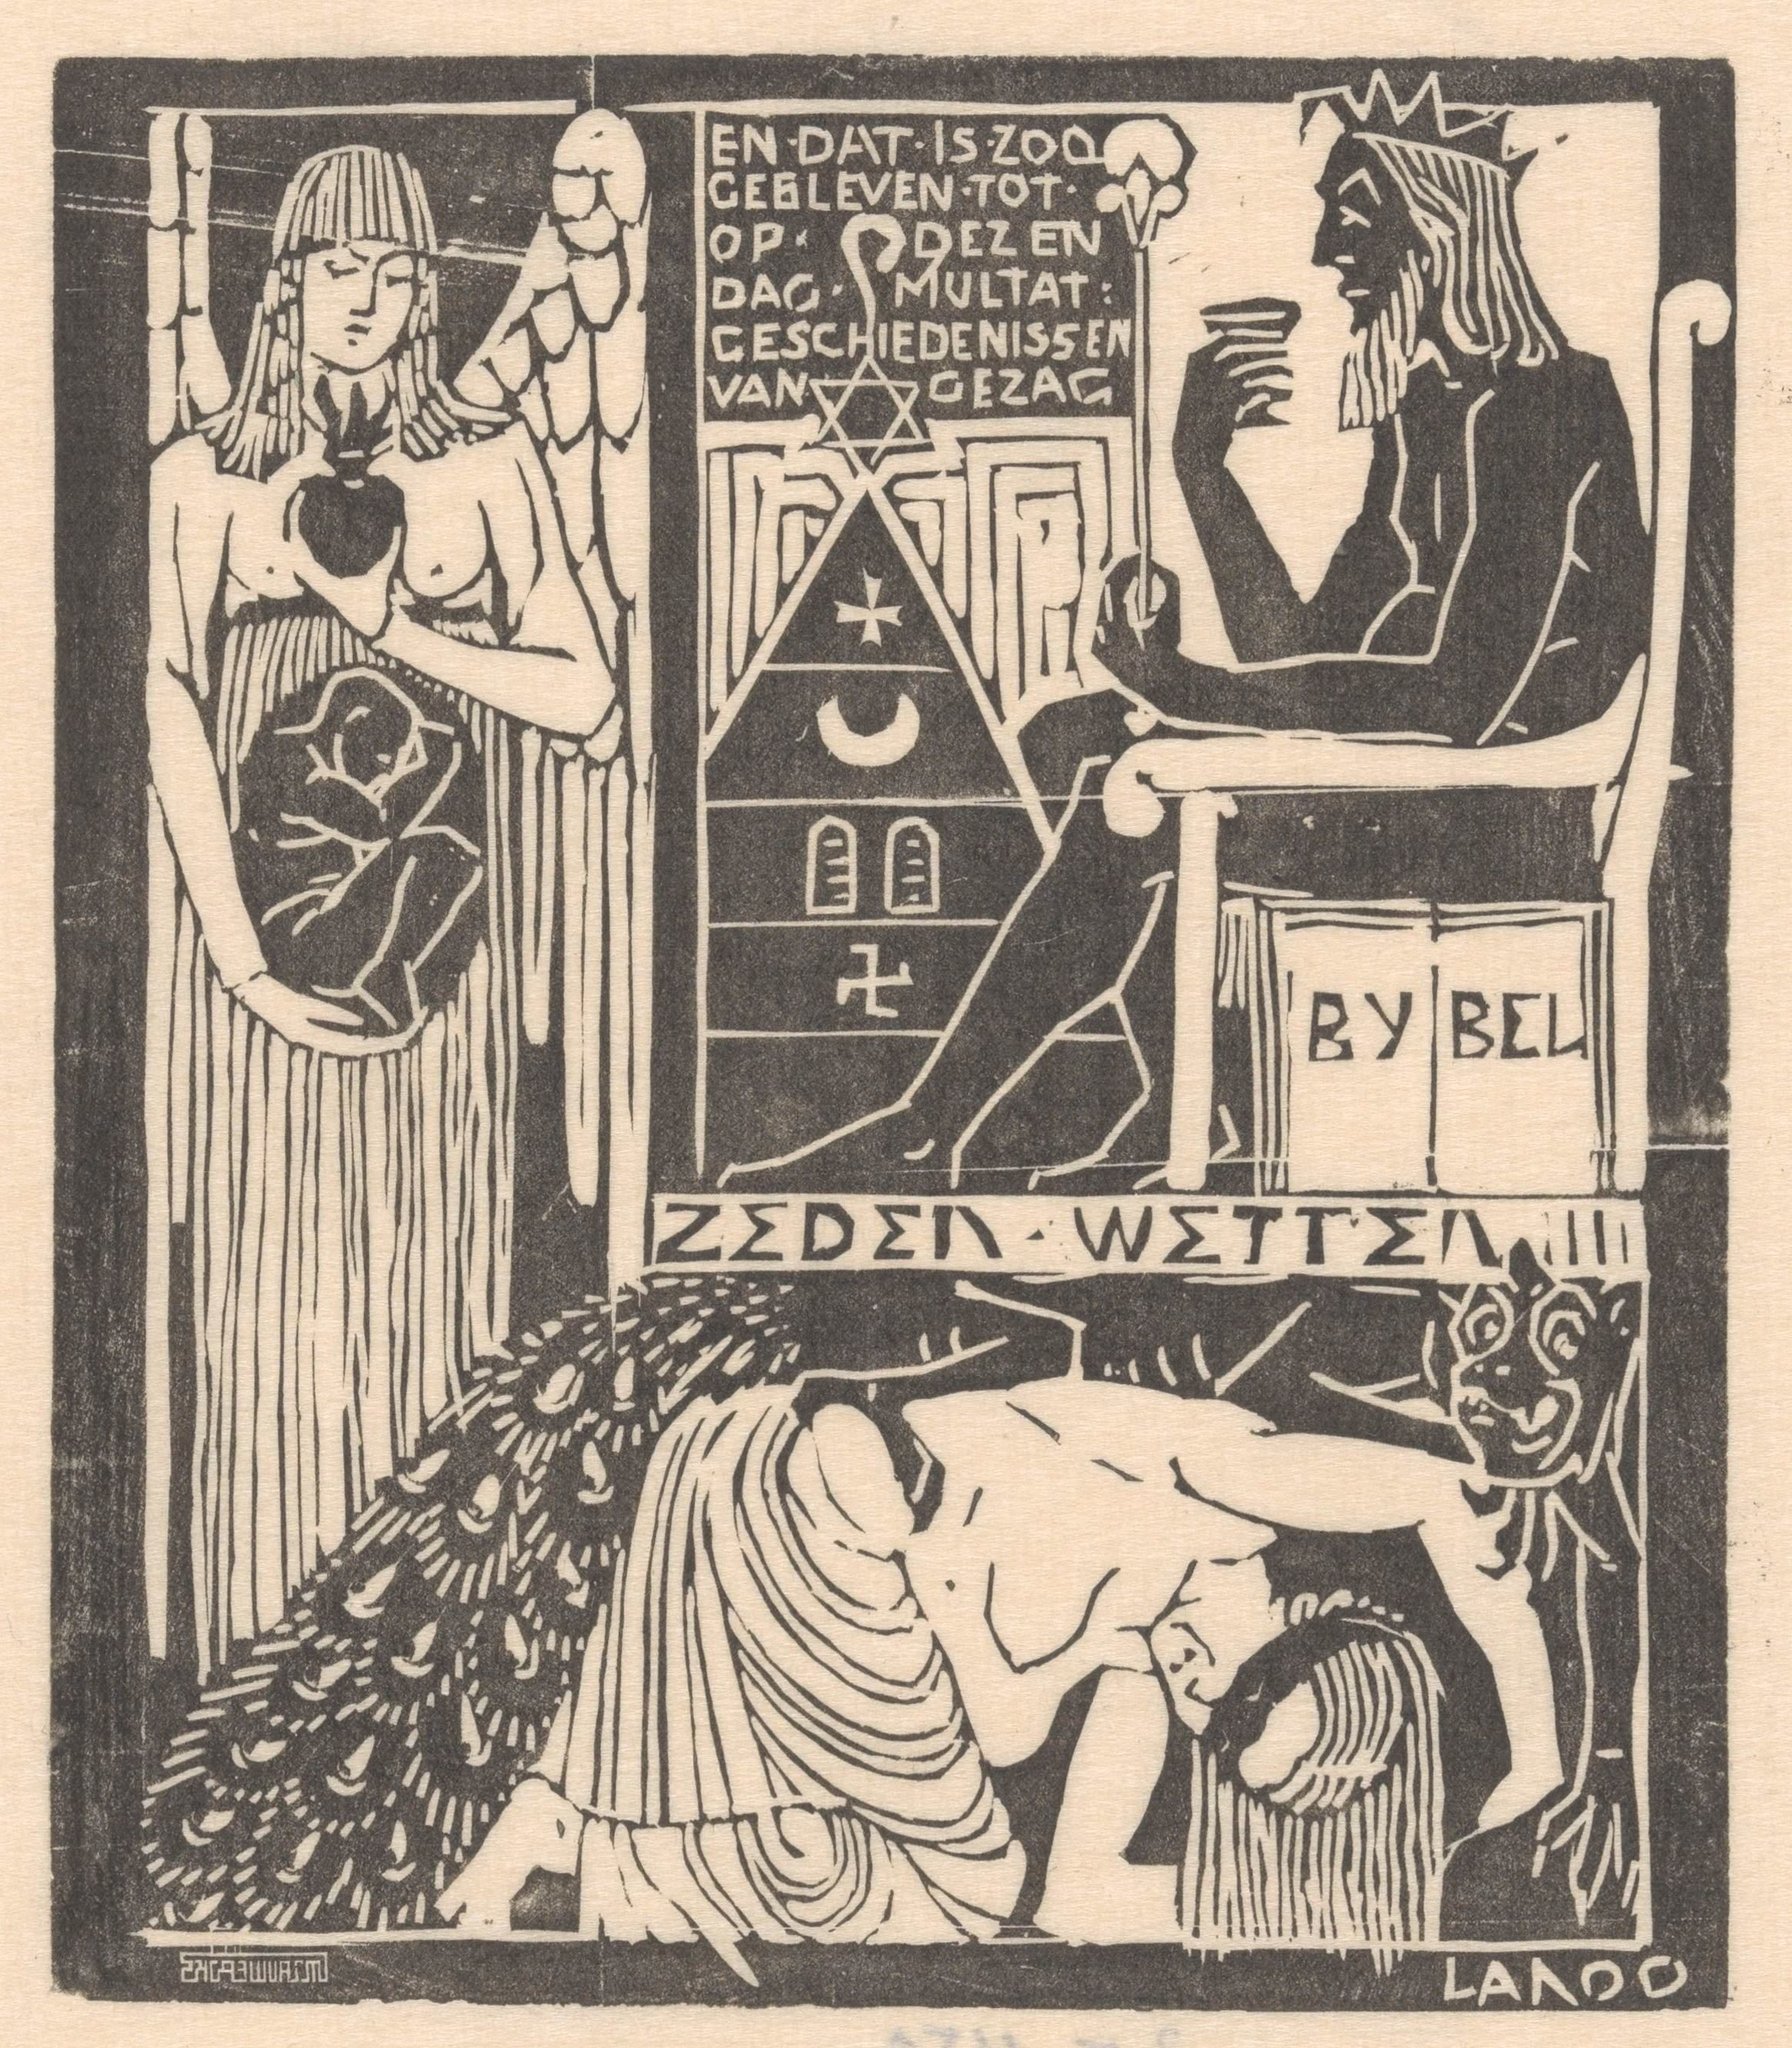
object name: print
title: Geblinddoekte vrouw en monster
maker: mathieu lauweriks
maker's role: designer, draughtsman, print maker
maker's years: 1864-1932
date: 1894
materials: paper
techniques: woodcut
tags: uterus with foetus - aa - female human figure, monsters ~ animals in general (of undetermined kind), the sacred heart, blindfold - aa - female human figure, the bible as a book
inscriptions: collector's mark: Lugt 2228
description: Een geblinddoekte vrouw zit op haar knieën met op haar rug een monster met een pauwenstaart. Boven haar de tekst 'zeden - wetten' en een bijbel. Daarboven zit een man met een kroon en een scepter op een stoel. Links staat een gevleugelde vrouw met in haar hand een heilig hart en in haar buik een figuur in foetushouding.